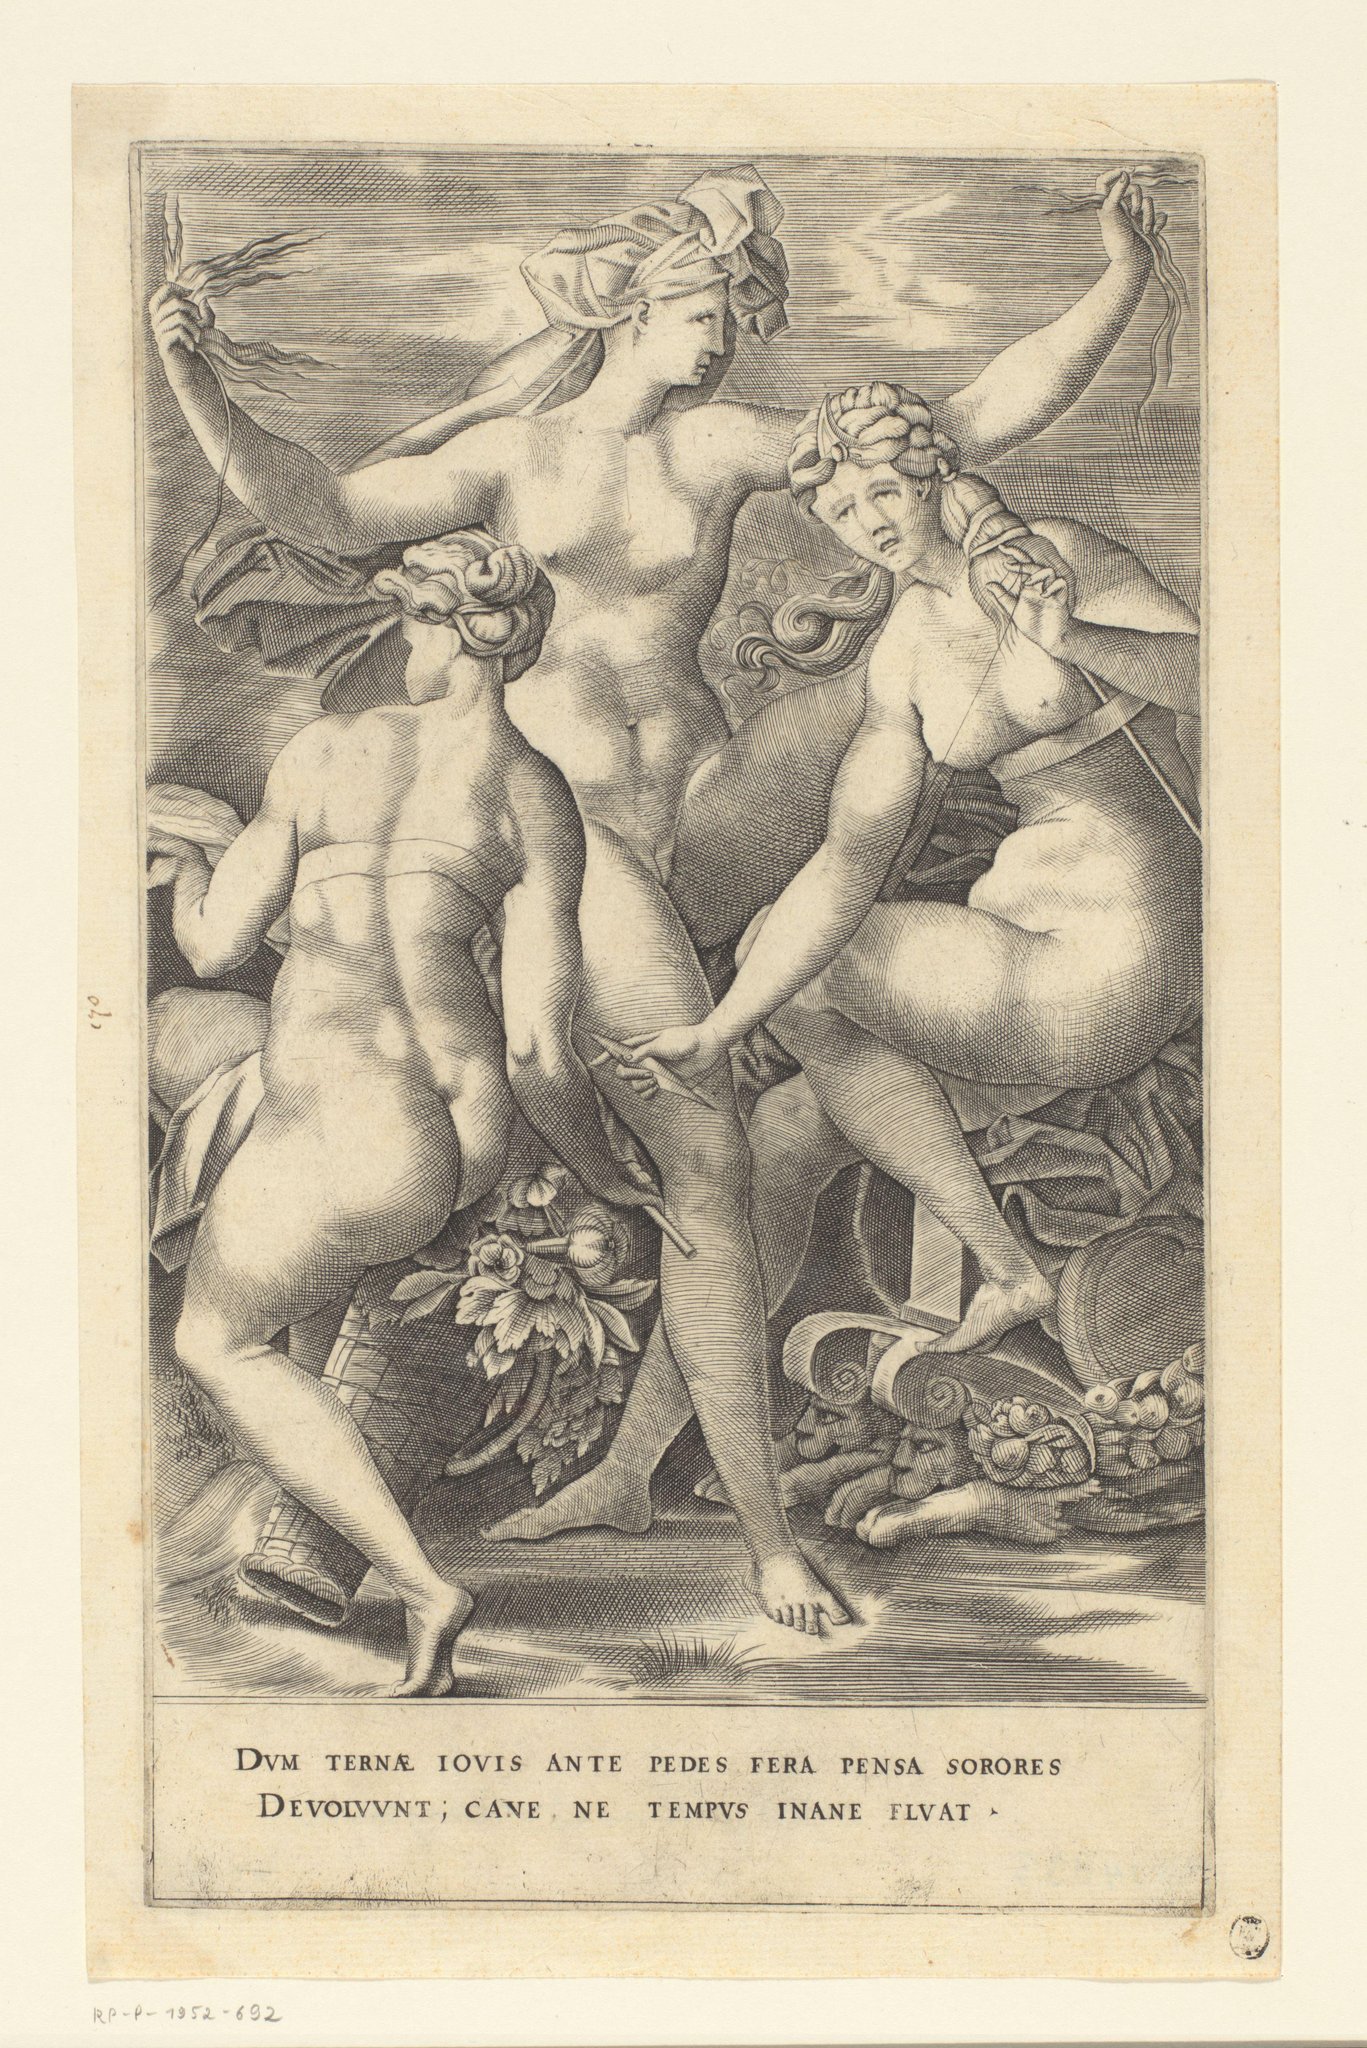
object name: print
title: Drie naakte Parcen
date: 1510-1557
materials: paper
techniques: engraving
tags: representations ~ goddesses, demi-goddesses, heroines, etc. (non-christian religions)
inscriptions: collector's mark: ‘E’, collector's mark: Lugt 2228